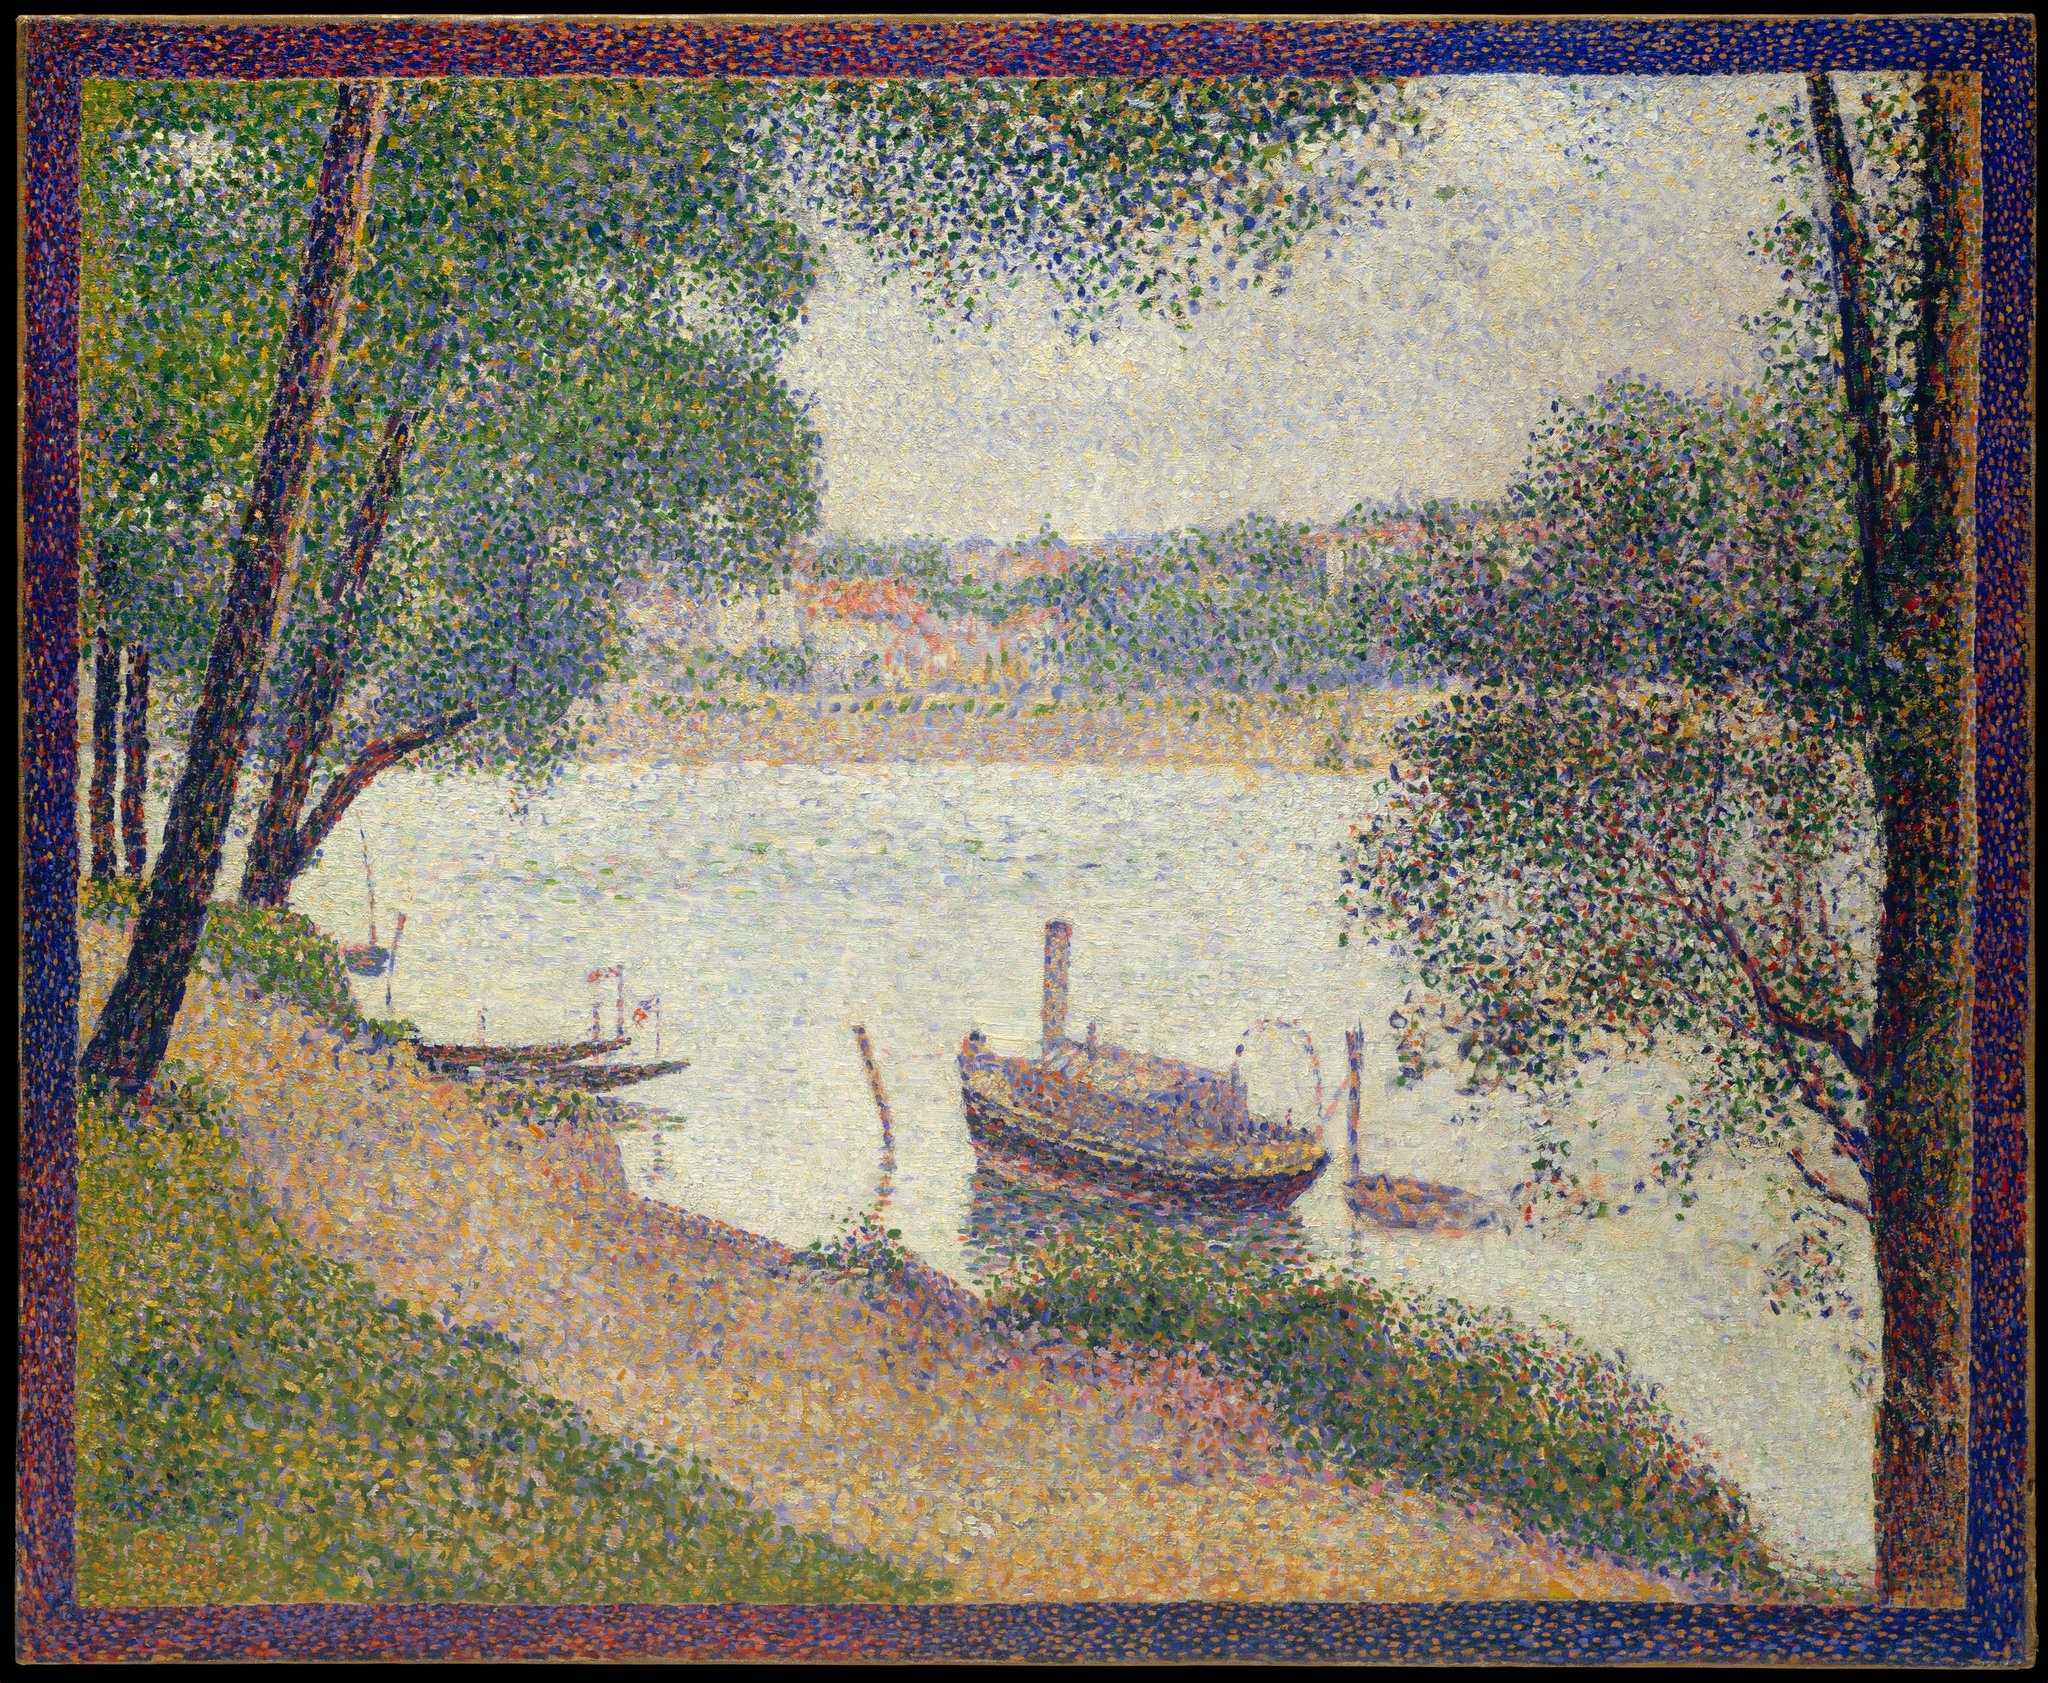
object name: painting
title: Gray Weather, Grande Jatte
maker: georges seurat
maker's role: artist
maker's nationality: french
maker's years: 1859-1891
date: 1886-1888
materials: canvas, oil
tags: rivers,boats